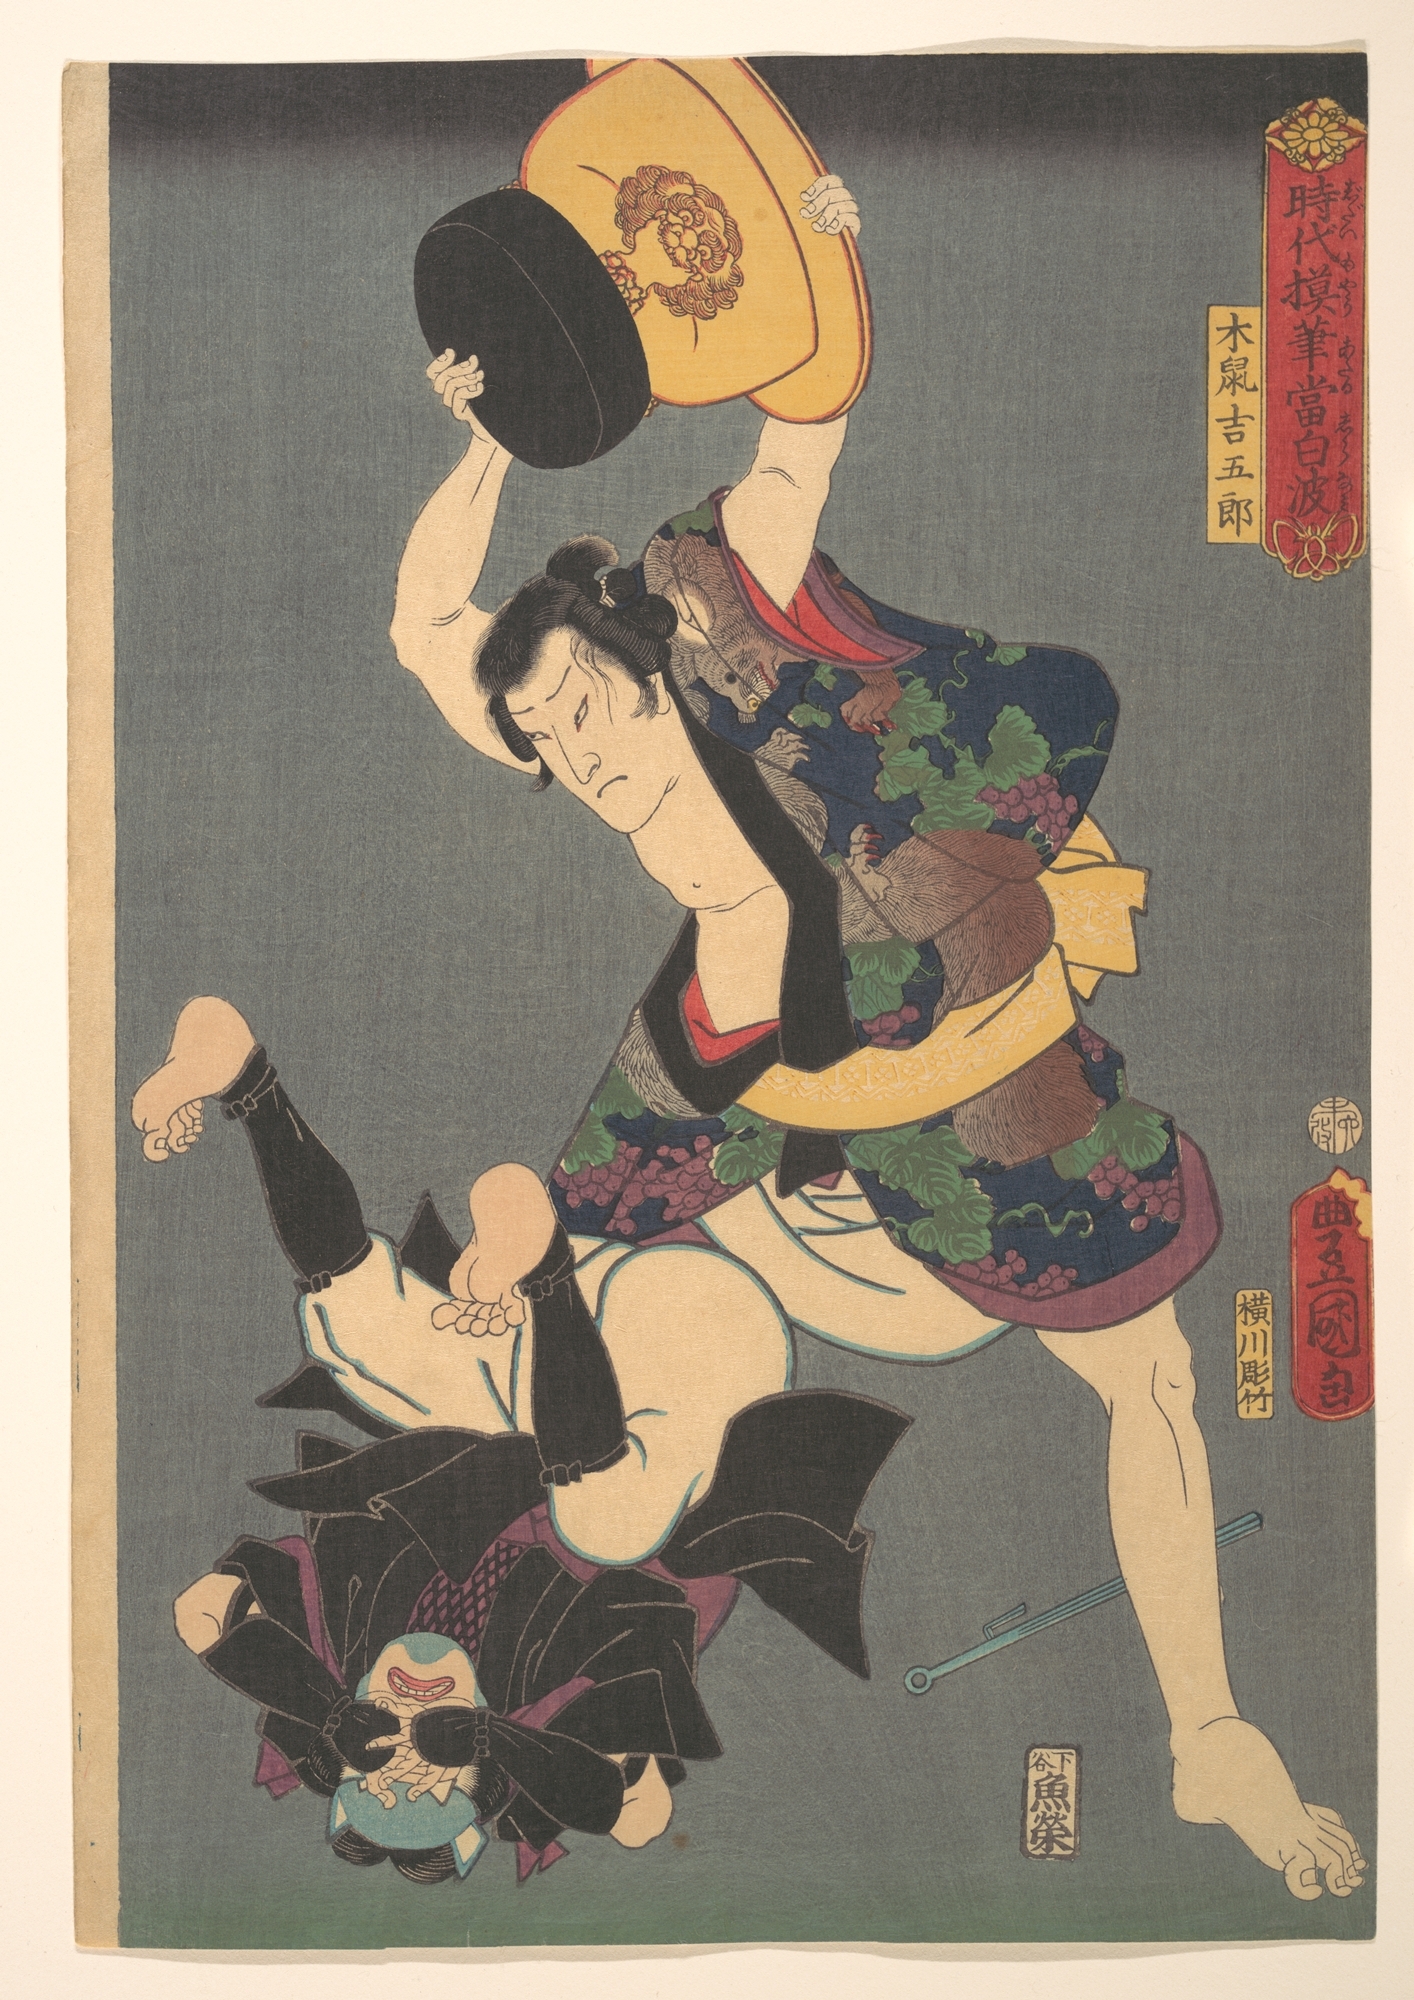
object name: print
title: Contemporary Rendition of a Rogue: Kinezumi Kichigorō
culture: japanese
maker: utagawa kunisada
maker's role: artist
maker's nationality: japanese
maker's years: 1786-1864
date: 1801-1900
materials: ink, paper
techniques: woodblock print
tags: men